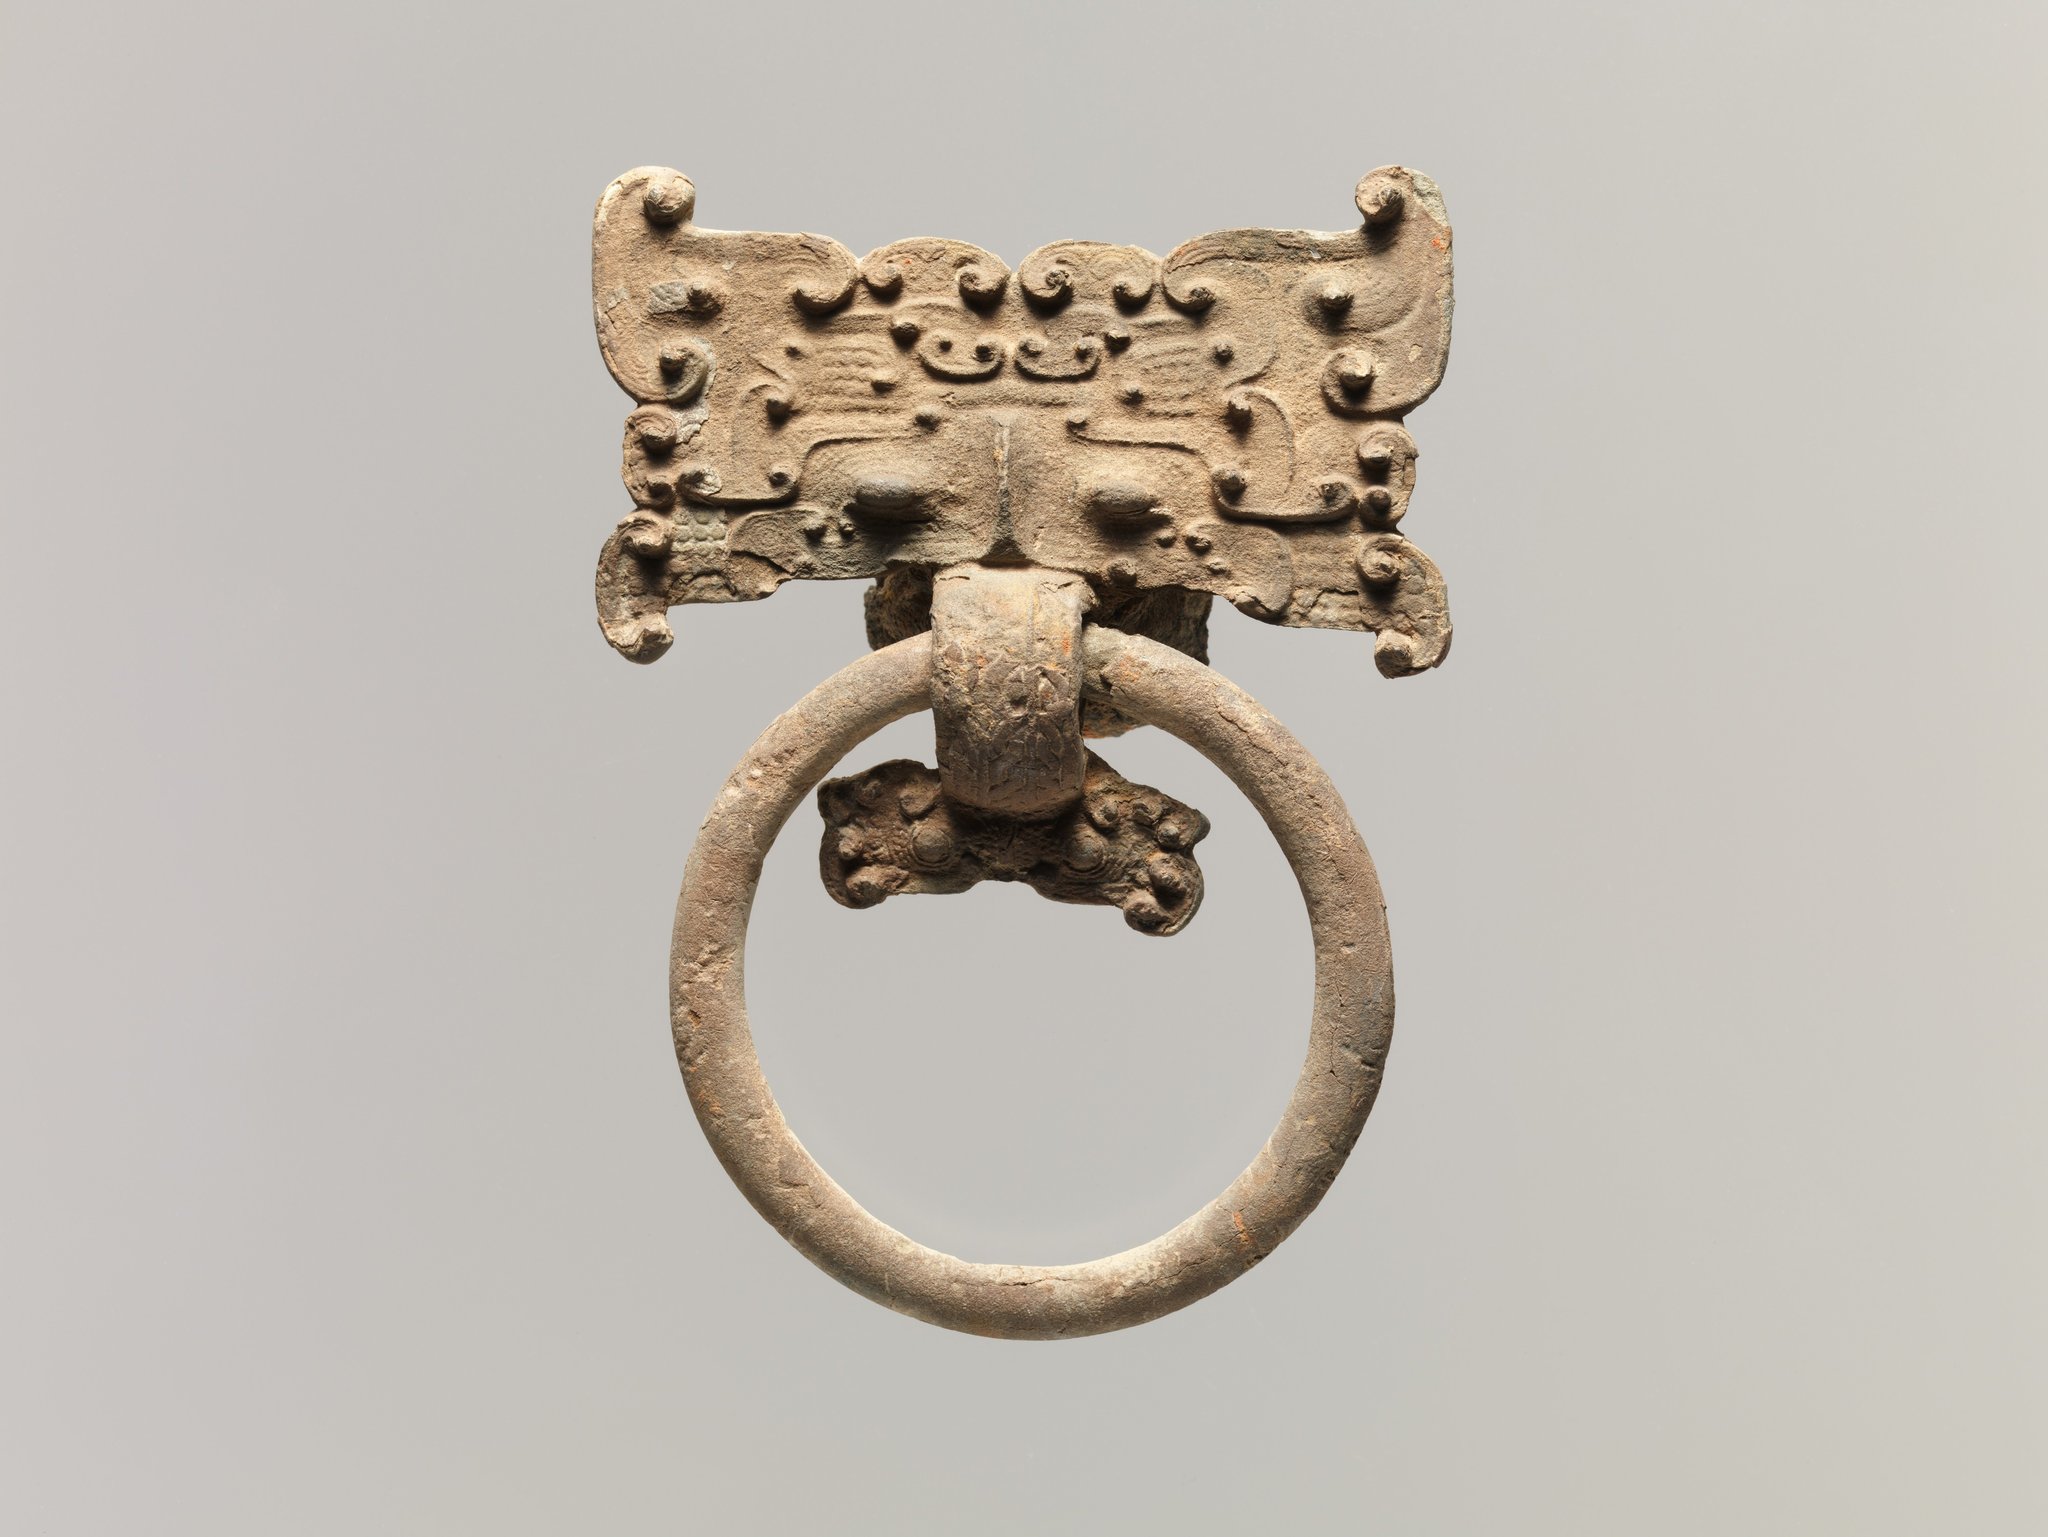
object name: ring handle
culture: chinese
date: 770-256 BCE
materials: bronze